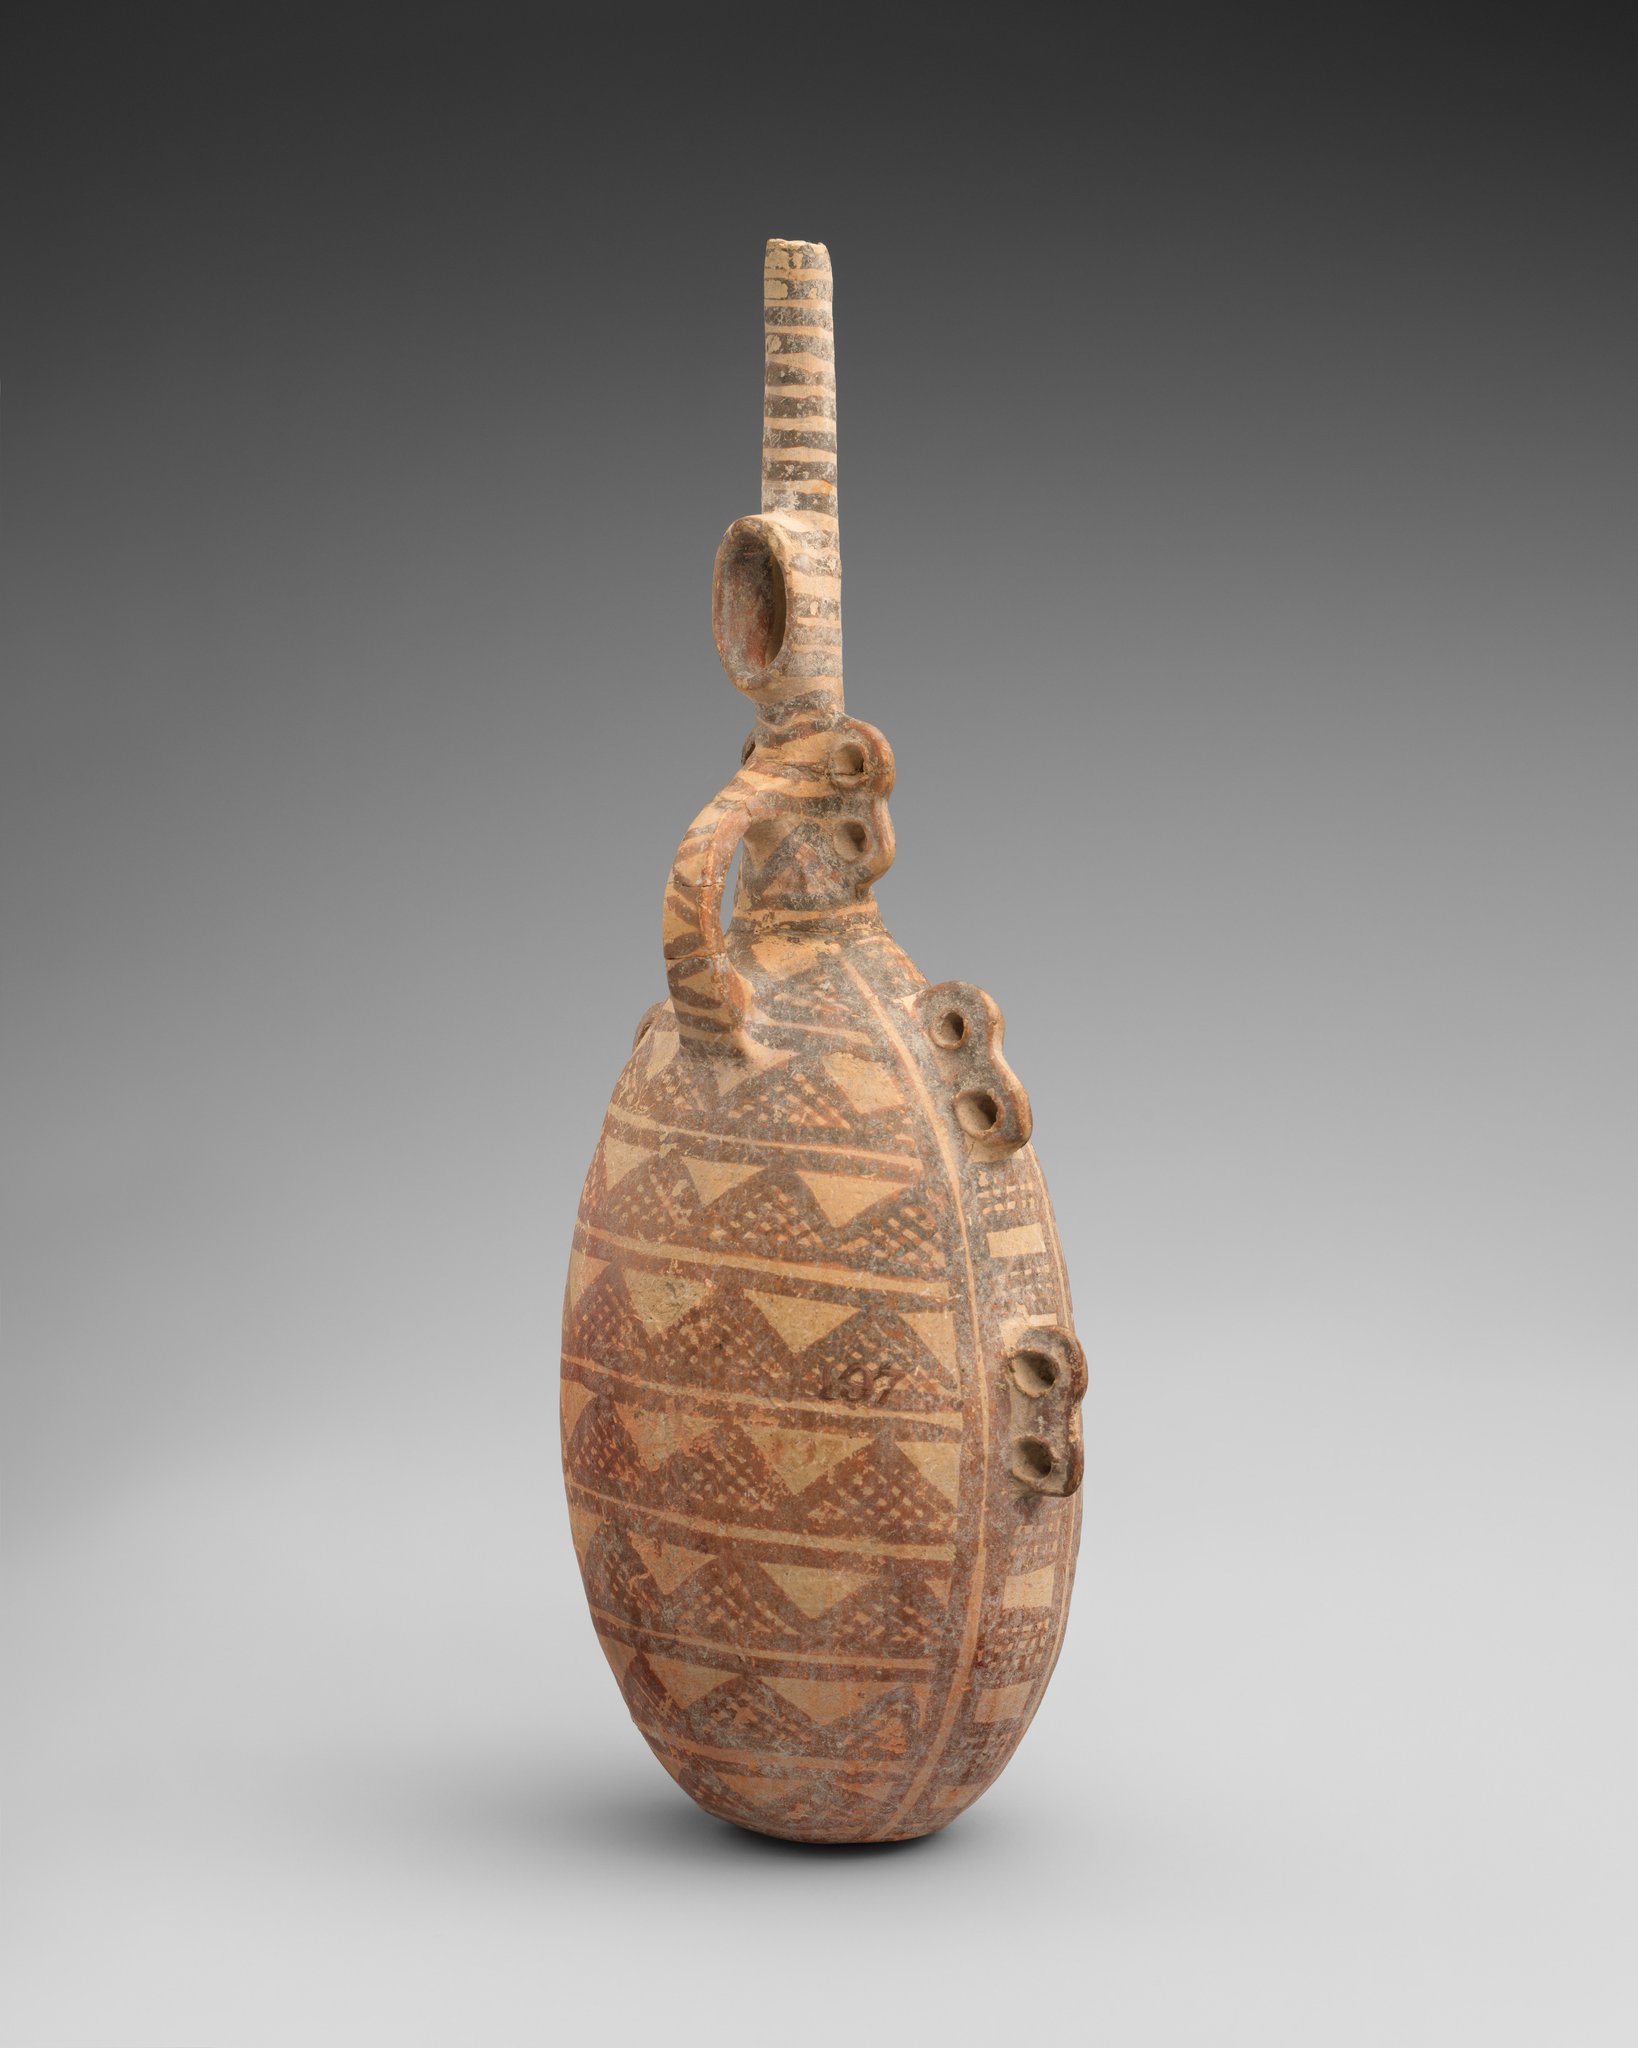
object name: jug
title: Terracotta jug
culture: cypriot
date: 1800-1725 BCE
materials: terracotta